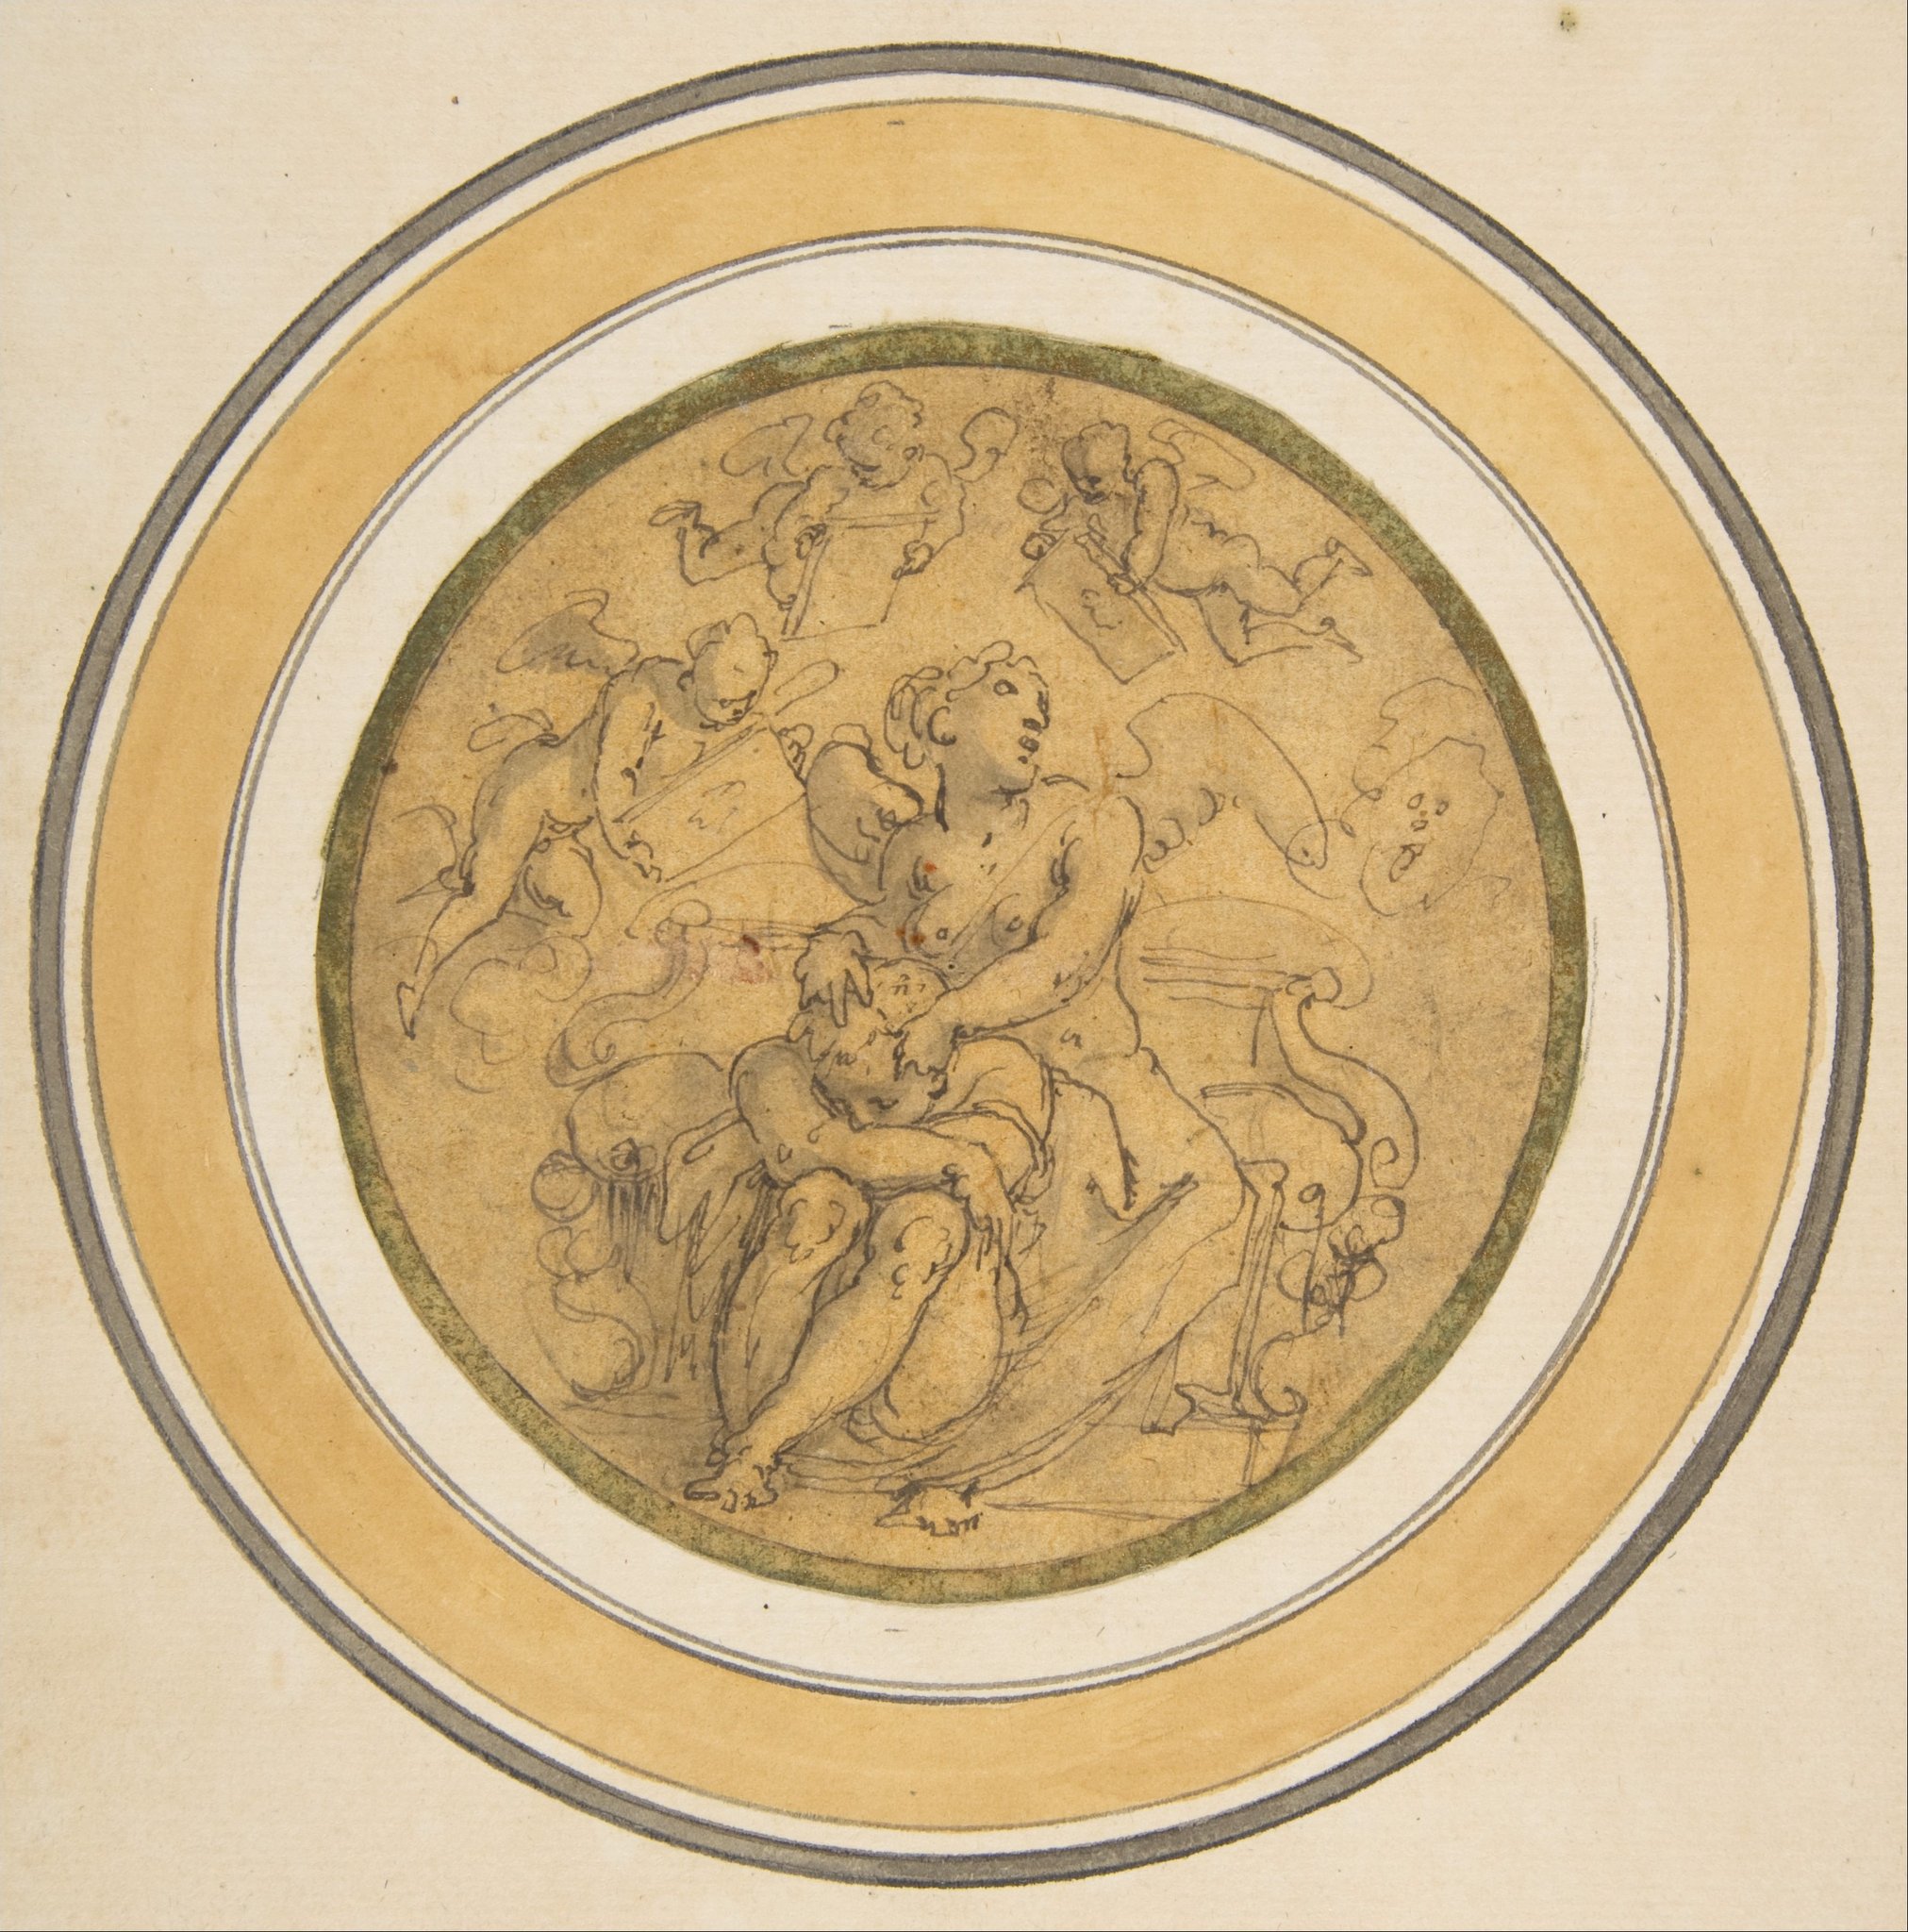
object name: drawing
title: Allegory of Sleep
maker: giorgio vasari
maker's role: artist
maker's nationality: italian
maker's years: 1511-1574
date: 1570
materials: chalk, ink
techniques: brush, pen, wash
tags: sleeping